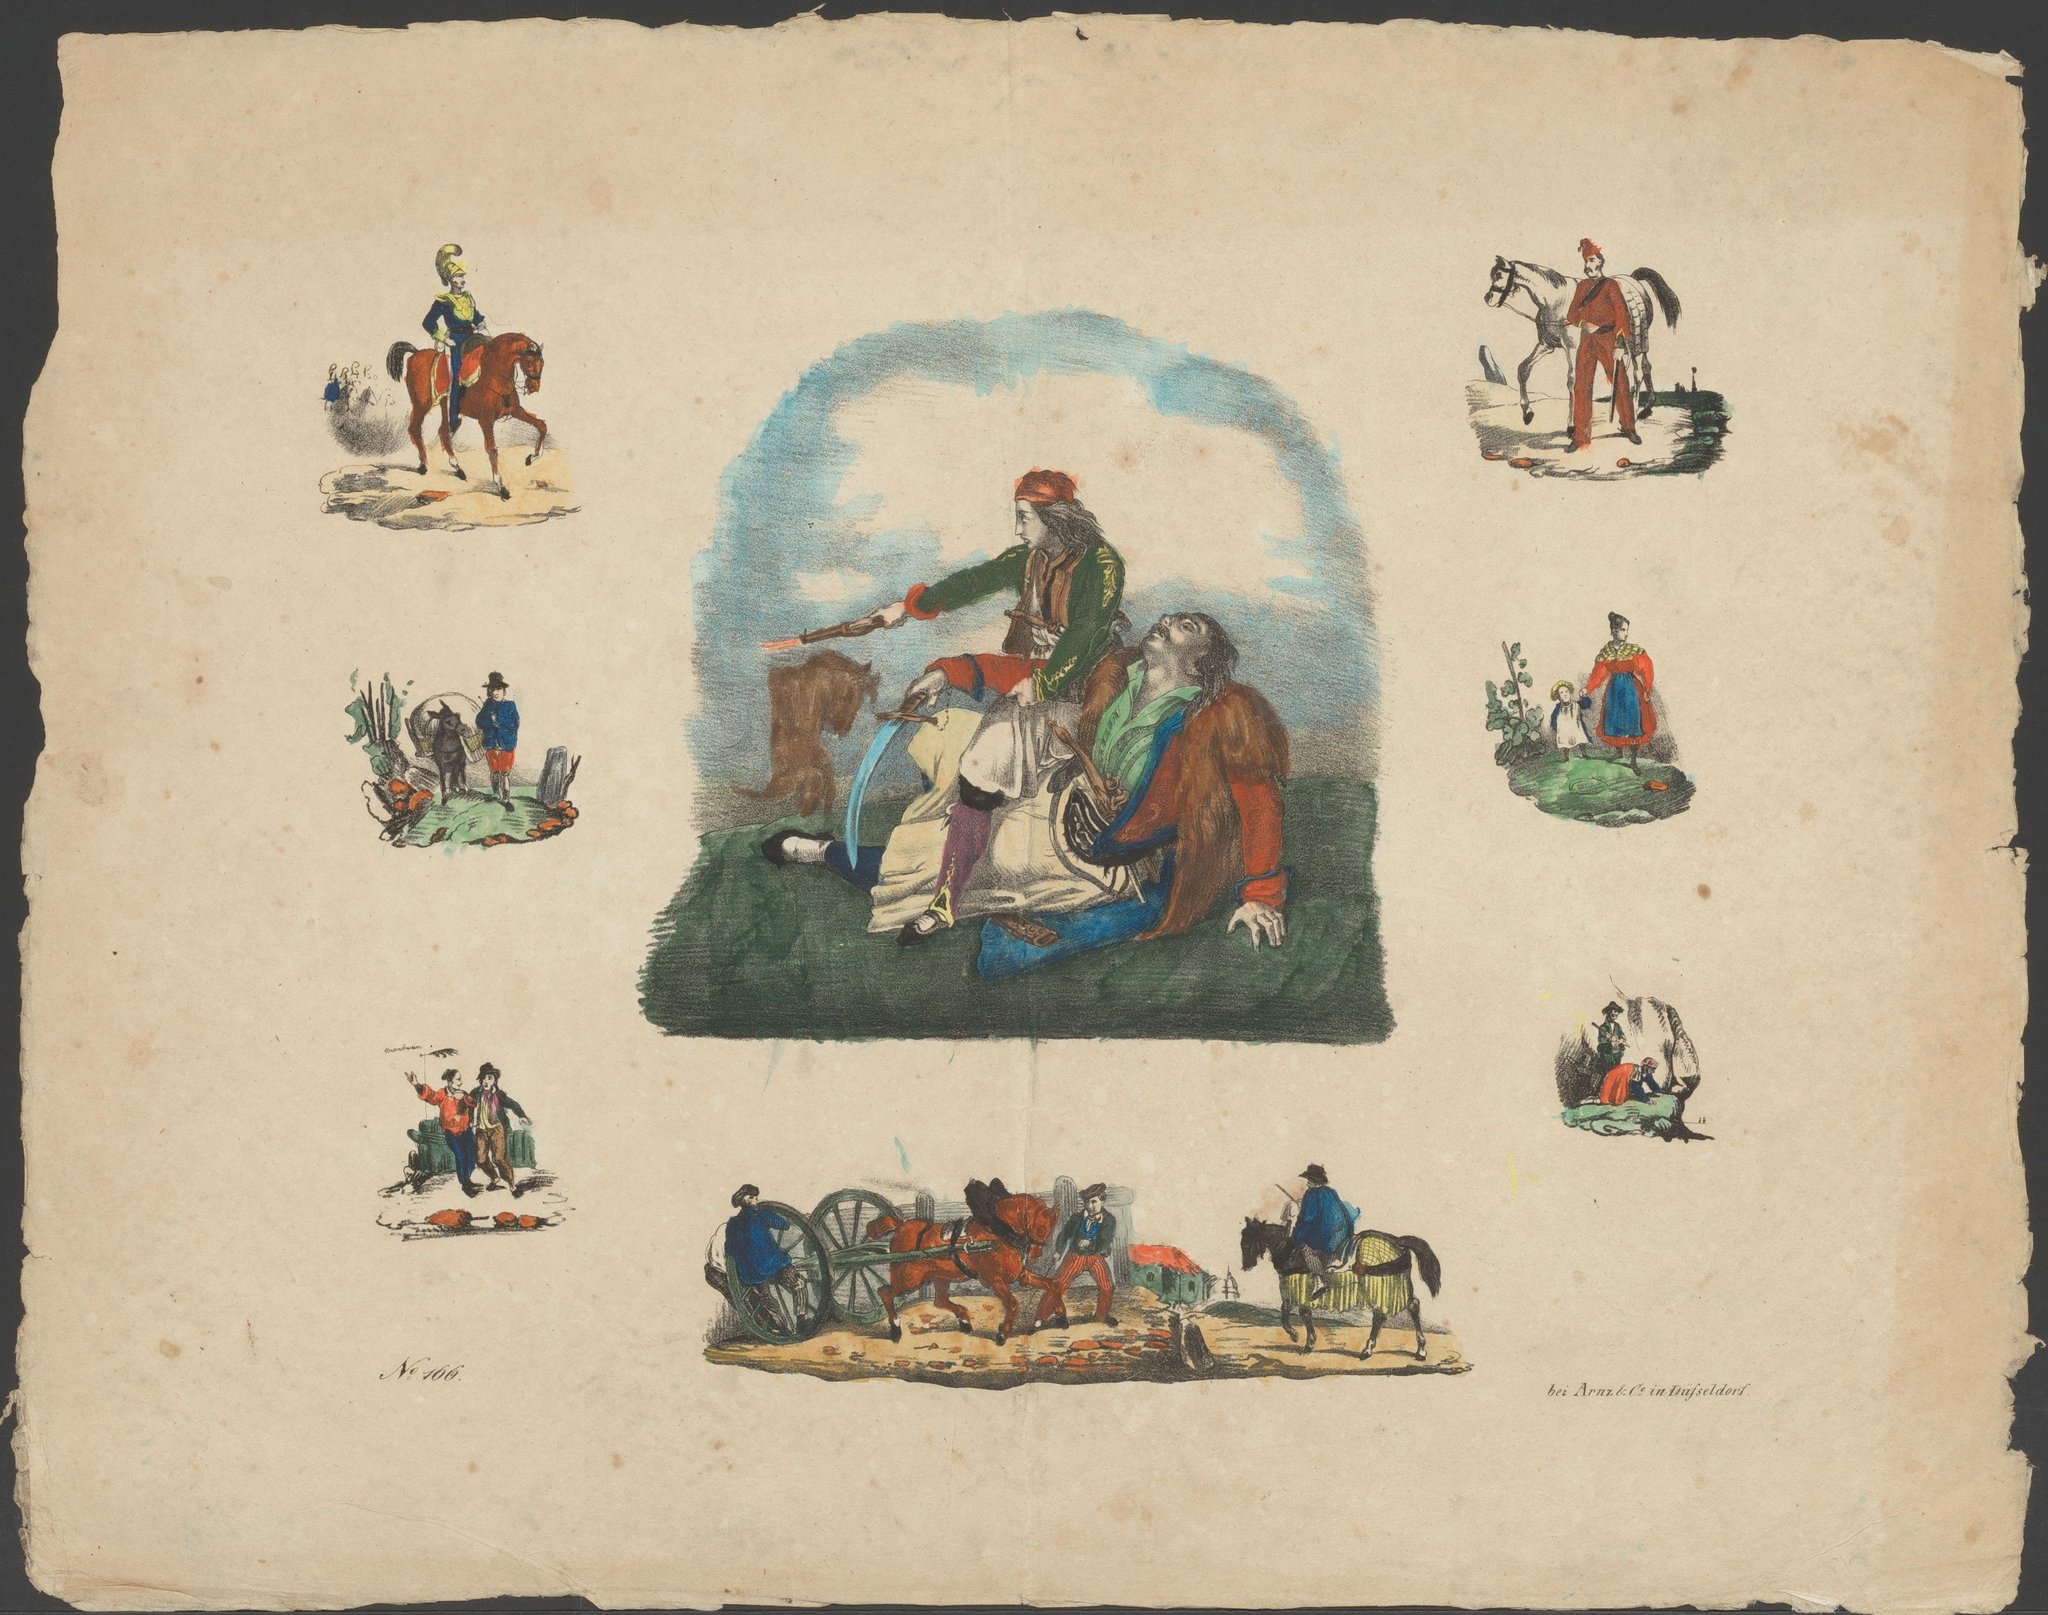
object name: popular print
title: Dieren in gevangenschap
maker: Anonymous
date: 1815-1858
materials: paper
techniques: hand coloring, lithograph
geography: dusseldorf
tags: traffic and transport, weapons, travelling; tourism, the soldier; the soldier's life, firearms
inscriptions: stamp, collector's mark: Lugt 1641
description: Een grote en zeven kleine afbeeldingen. In het midden een grote afbeelding van een stervende soldaat en een schietende jonge soldaat. Zeven kleine afbeeldingen met verschillende reizende gezelschappen. Linksonder genummerd: No. 166. Onderwerpsrubrieken binnen de Atlas Zeden en Gewoonten: Zeden en Gewoonten in Engeren Zin, Des menschen beging, midden en einde, Kinderleven – Kinderspel en Kinderprenten.